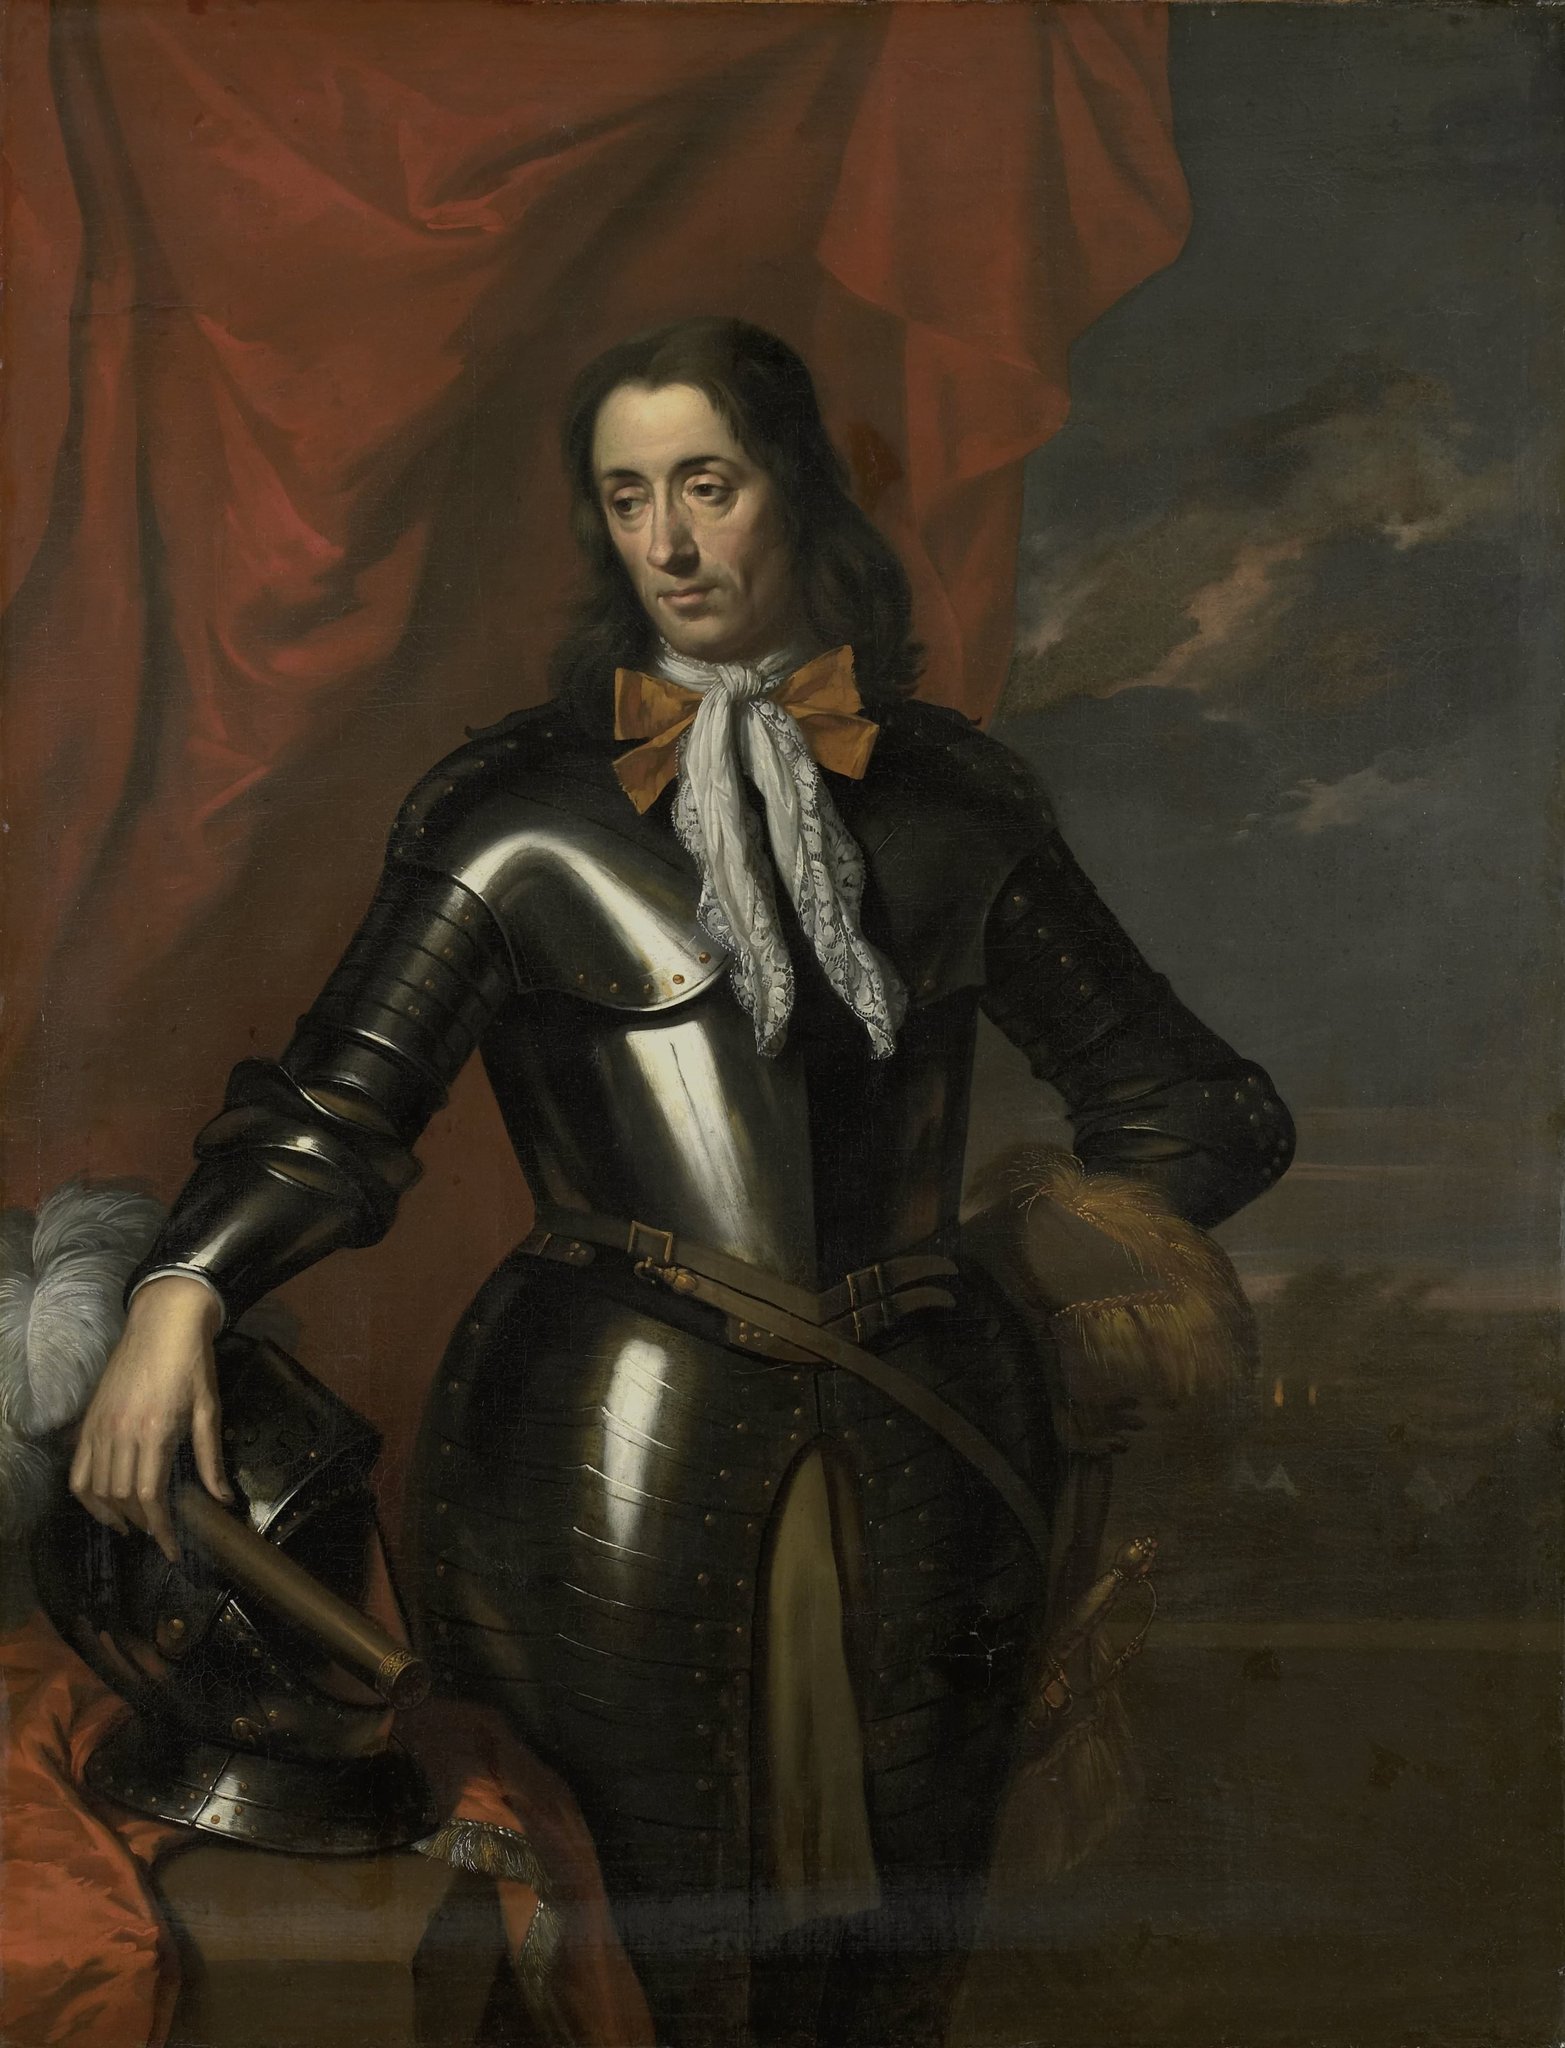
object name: painting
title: Isaac de l'Ostal de Saint-Martin (c 1629-96), Councillor of the Dutch East Indies and Commander of the Garrison at Batavia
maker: jan de baen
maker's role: draughtsman, print maker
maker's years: 1633-1702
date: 1650-1702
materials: canvas, oil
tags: batavia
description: Isaac de l'Ostal de Saint-Martin, by Jan de Baen (?) (c. 1660-1670). Frenchman Isaac de l'Ostal de Saint-Martin (c. 1629-1696) enjoyed a glorious career as a soldier in the service of the VOC between 1657 and 1683. He was stationed at Sri Lanka (Ceylon), Malabar and Ternate. He also fought several hostile Indonesians. In 1683 De Saint-Martin returned to the Netherlands in command of a fleet, only to return two years later to Batavia. He was appointed to the council of the Indies. Chaired by the governor-general, this body was the Dutch administration in Asia. De Saint-Martin remained on the council until his death in 1696. De Saint Martin is depicted as a senior military officer, rather than as a bureaucrat. In his hand is his staff of command. The painting must have been made in the Netherlands, perhaps during his short stay here, or perhaps even earlier.